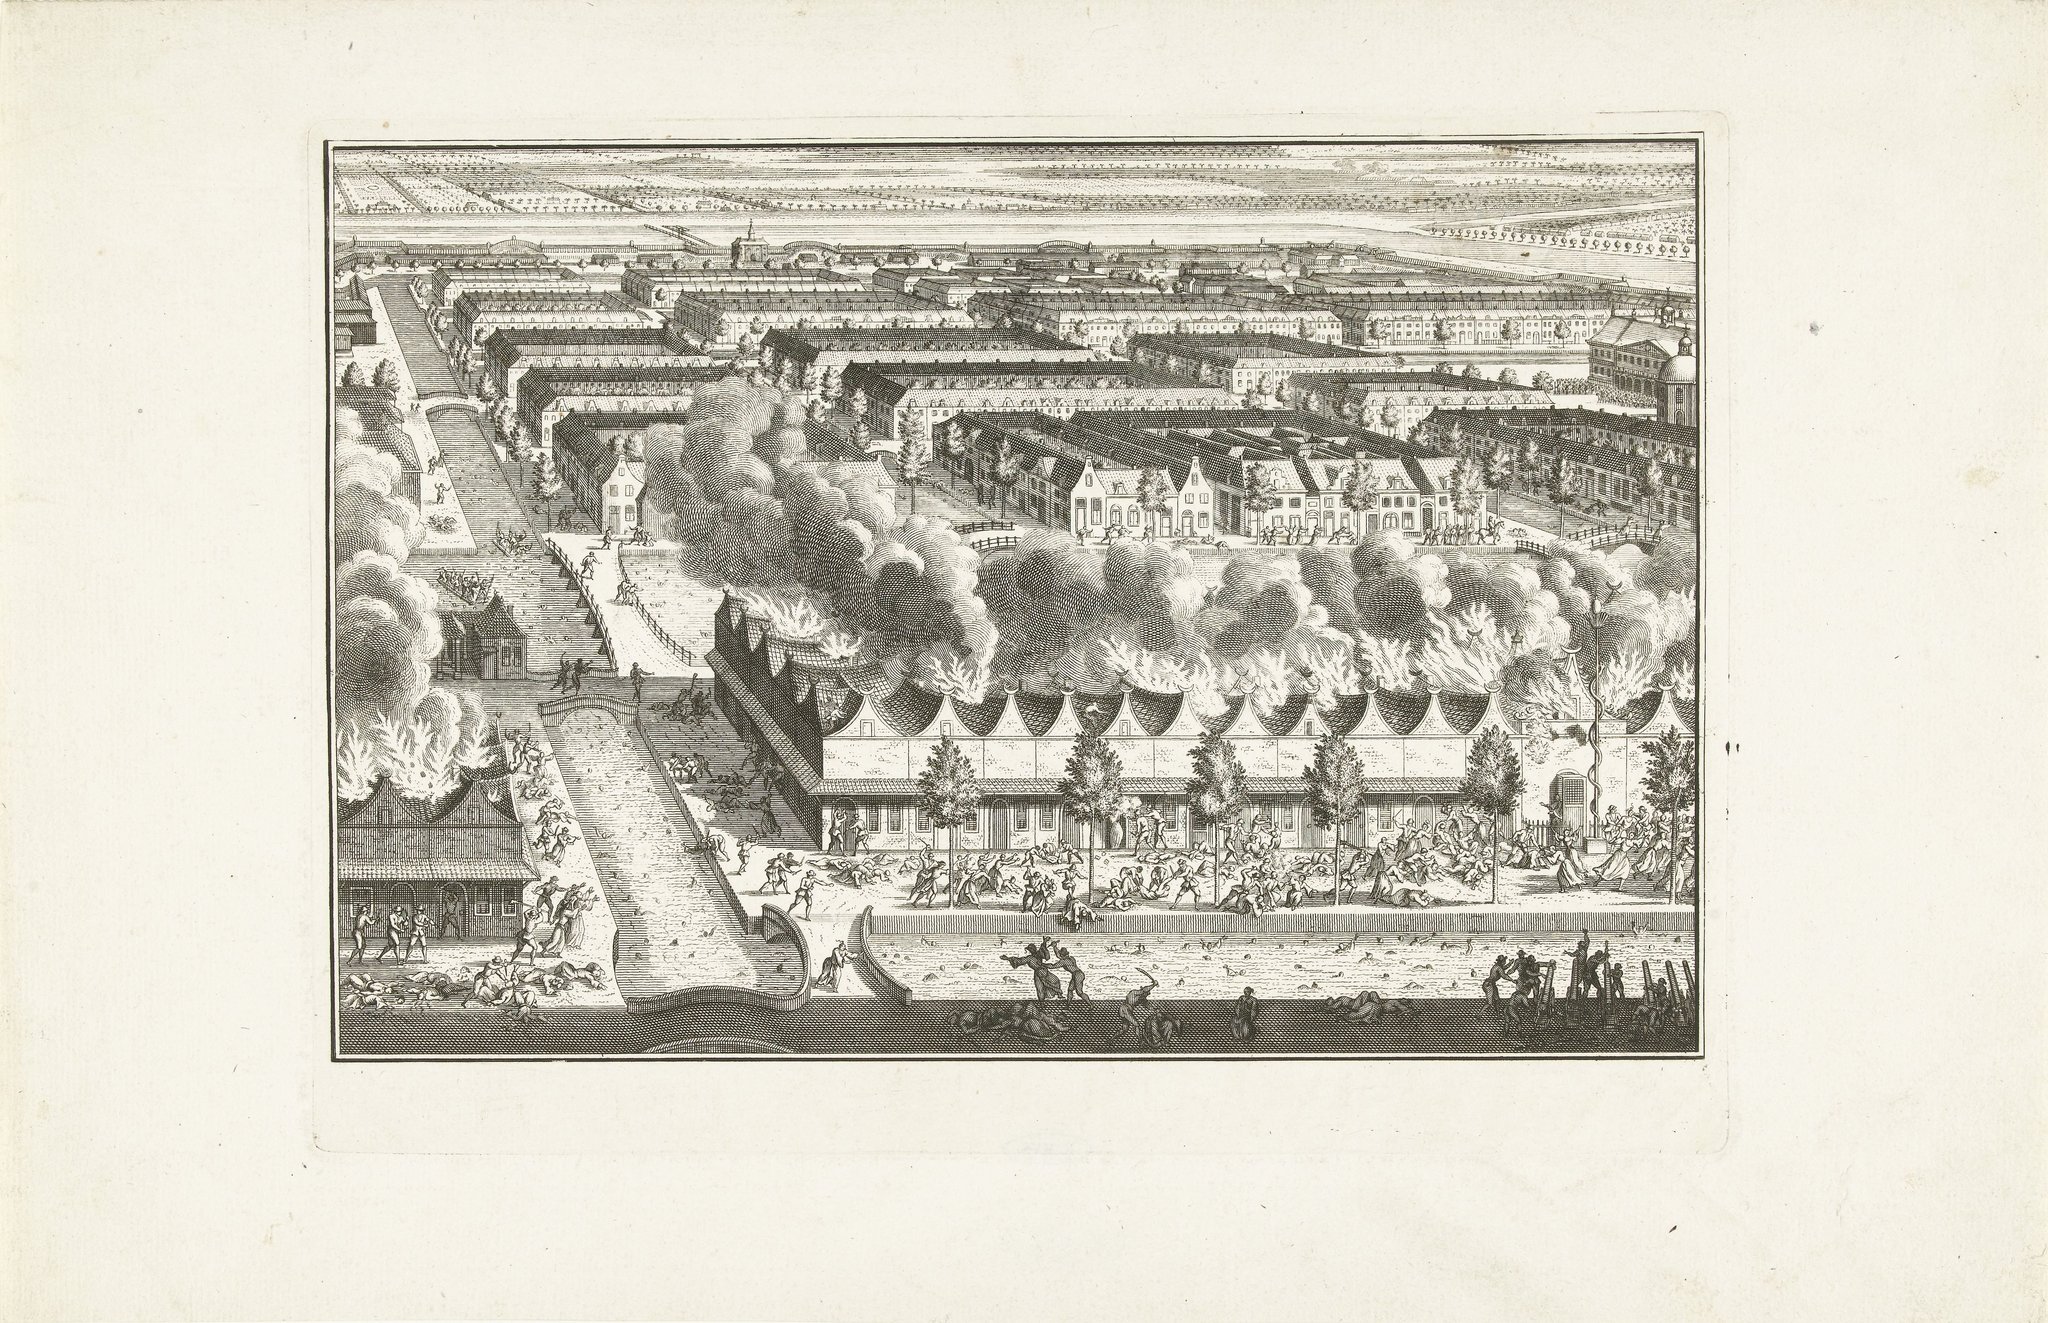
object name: print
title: Moord op Chinezen te Batavia, 1740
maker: jacob van der schley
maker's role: draughtsman, print maker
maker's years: 1715-1779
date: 1761-1763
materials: paper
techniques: etching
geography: northern netherlands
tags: massacre ~ war, batavia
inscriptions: collector's mark: Lugt 2228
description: De massamoord op de Chinezen door de Nederlanders in de Chinese wijk van Batavia, na de ontdekking van het vermeende verraad, 9 oktober 1740. De straten en grachten liggen vol met de lichamen van vermoorde Chinezen. Op de voorgrond staat het Chinese huizenblok in brand, rechts de beschieting met kanonnen van het huis van de Chinese kapitein gemarkeerd door de paal met de slang; de kapitein die in vrouwenkleren probeert te vluchten wordt gevangengenomen.